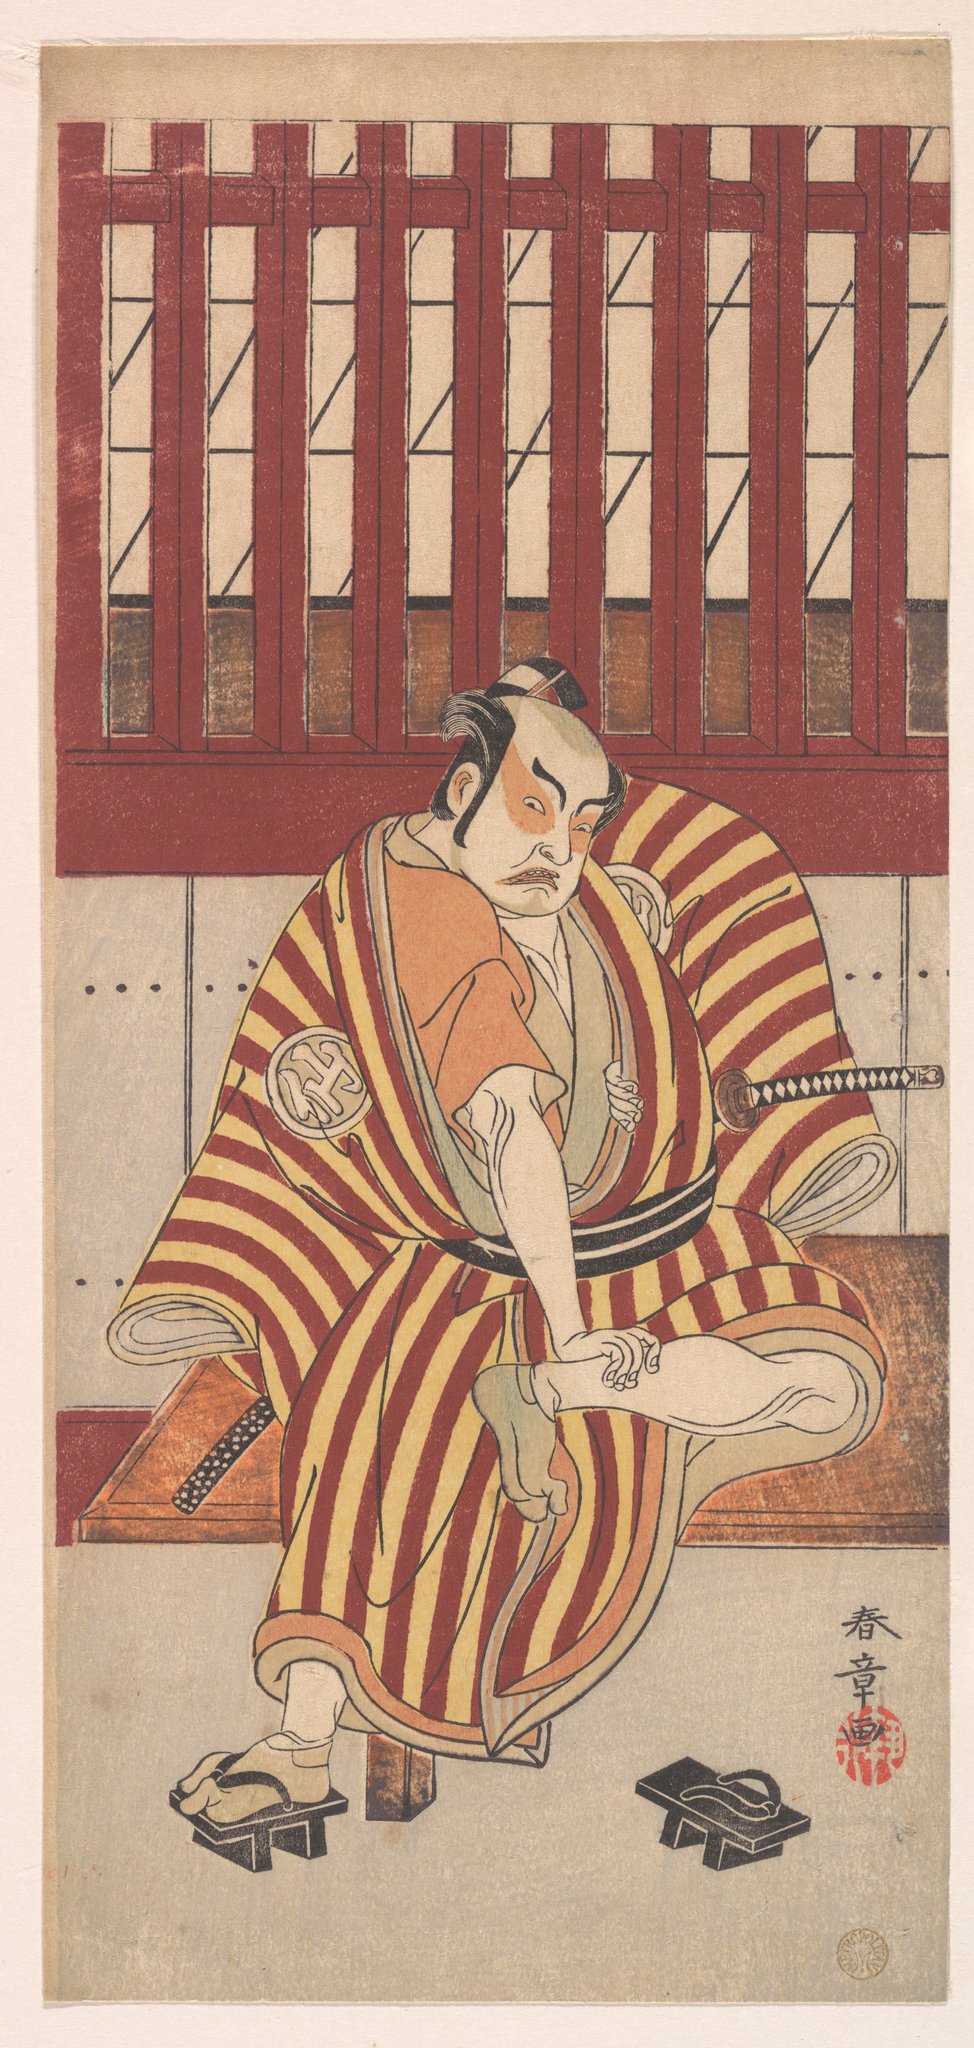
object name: woodblock print nishiki e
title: The Second Nakamura Sukegoro as an Otokodate Seated on a Wooden Bench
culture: japanese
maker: katsukawa shunshō 勝川春章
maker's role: artist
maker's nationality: japanese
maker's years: 1726-1792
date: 1771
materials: ink, paper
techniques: nishiki e, woodblock print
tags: footwear,men,actors